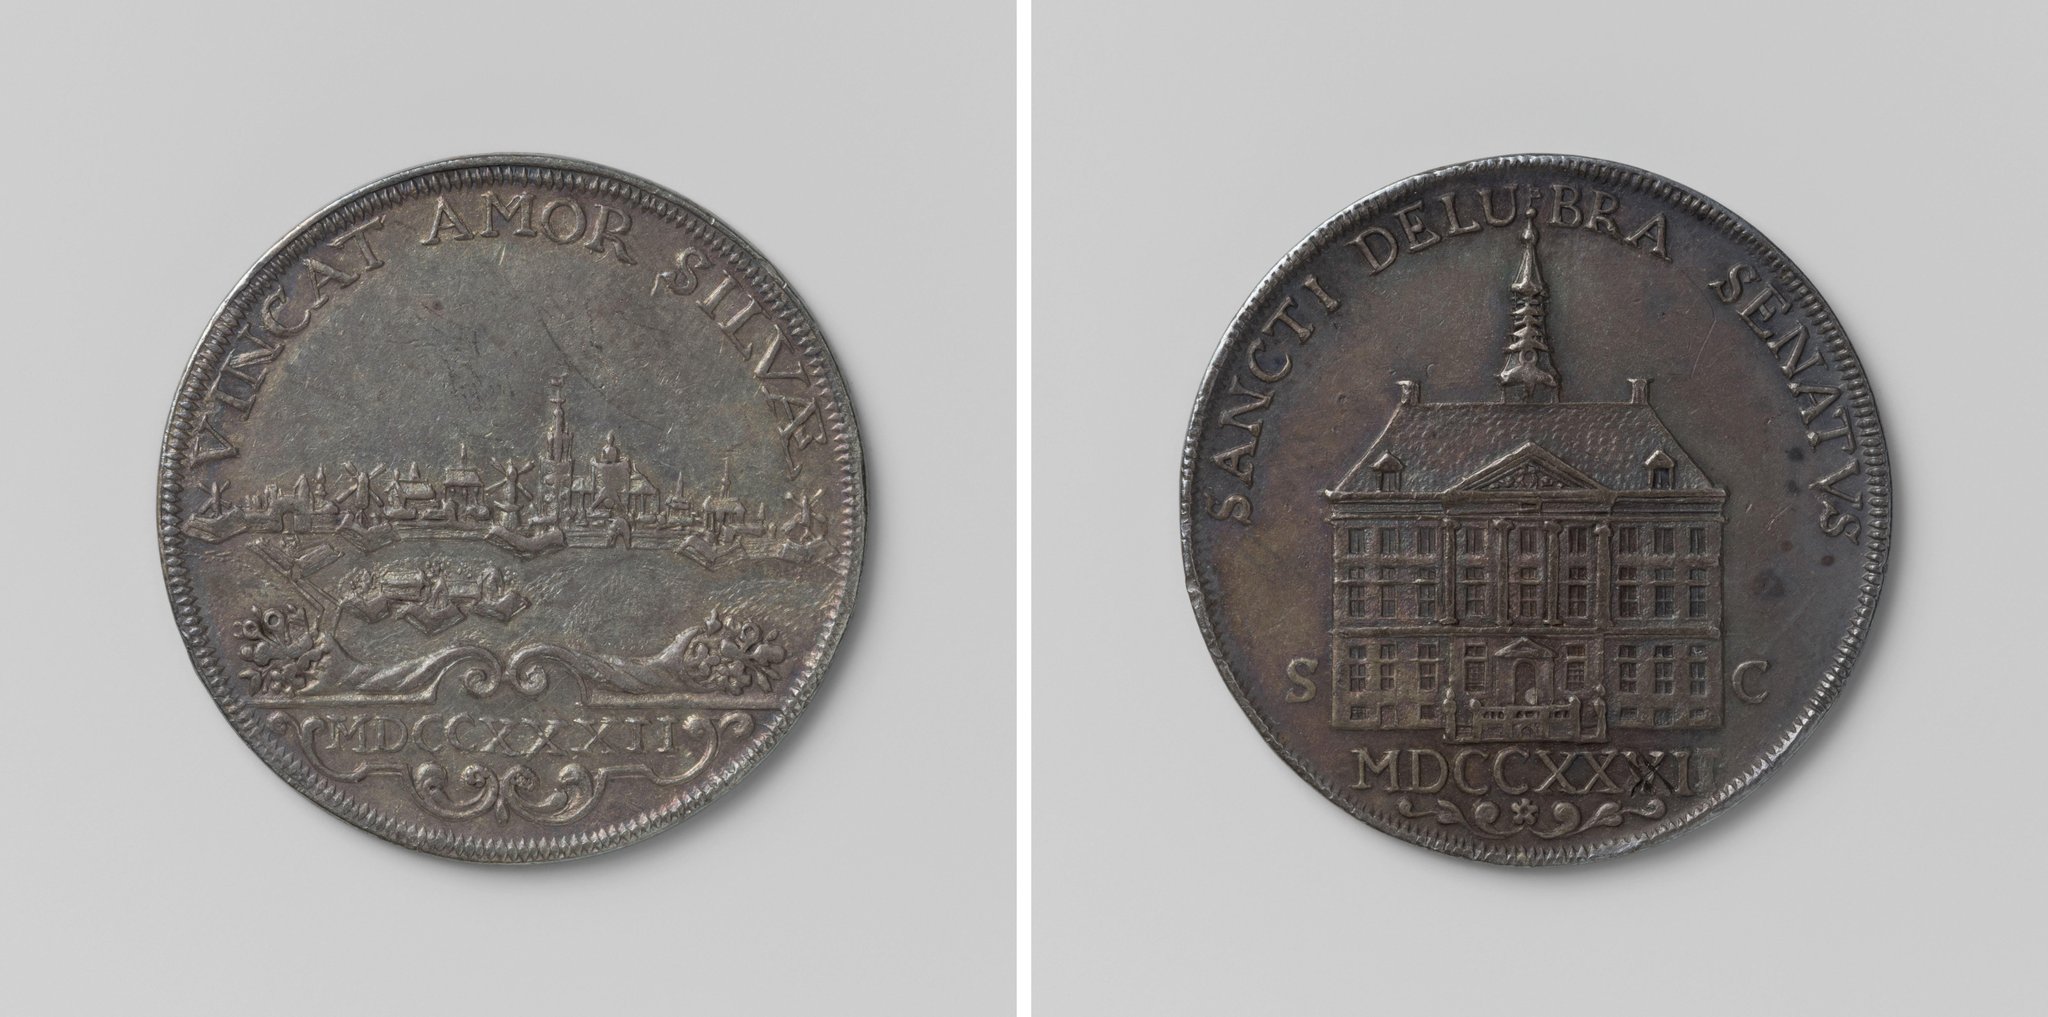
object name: council medal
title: Vroedschapspenning van de stad 's-Hertogenbosch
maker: theodorus casparus van berckel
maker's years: 1680-1734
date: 1732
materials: silver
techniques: striking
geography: den bosch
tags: den bosch